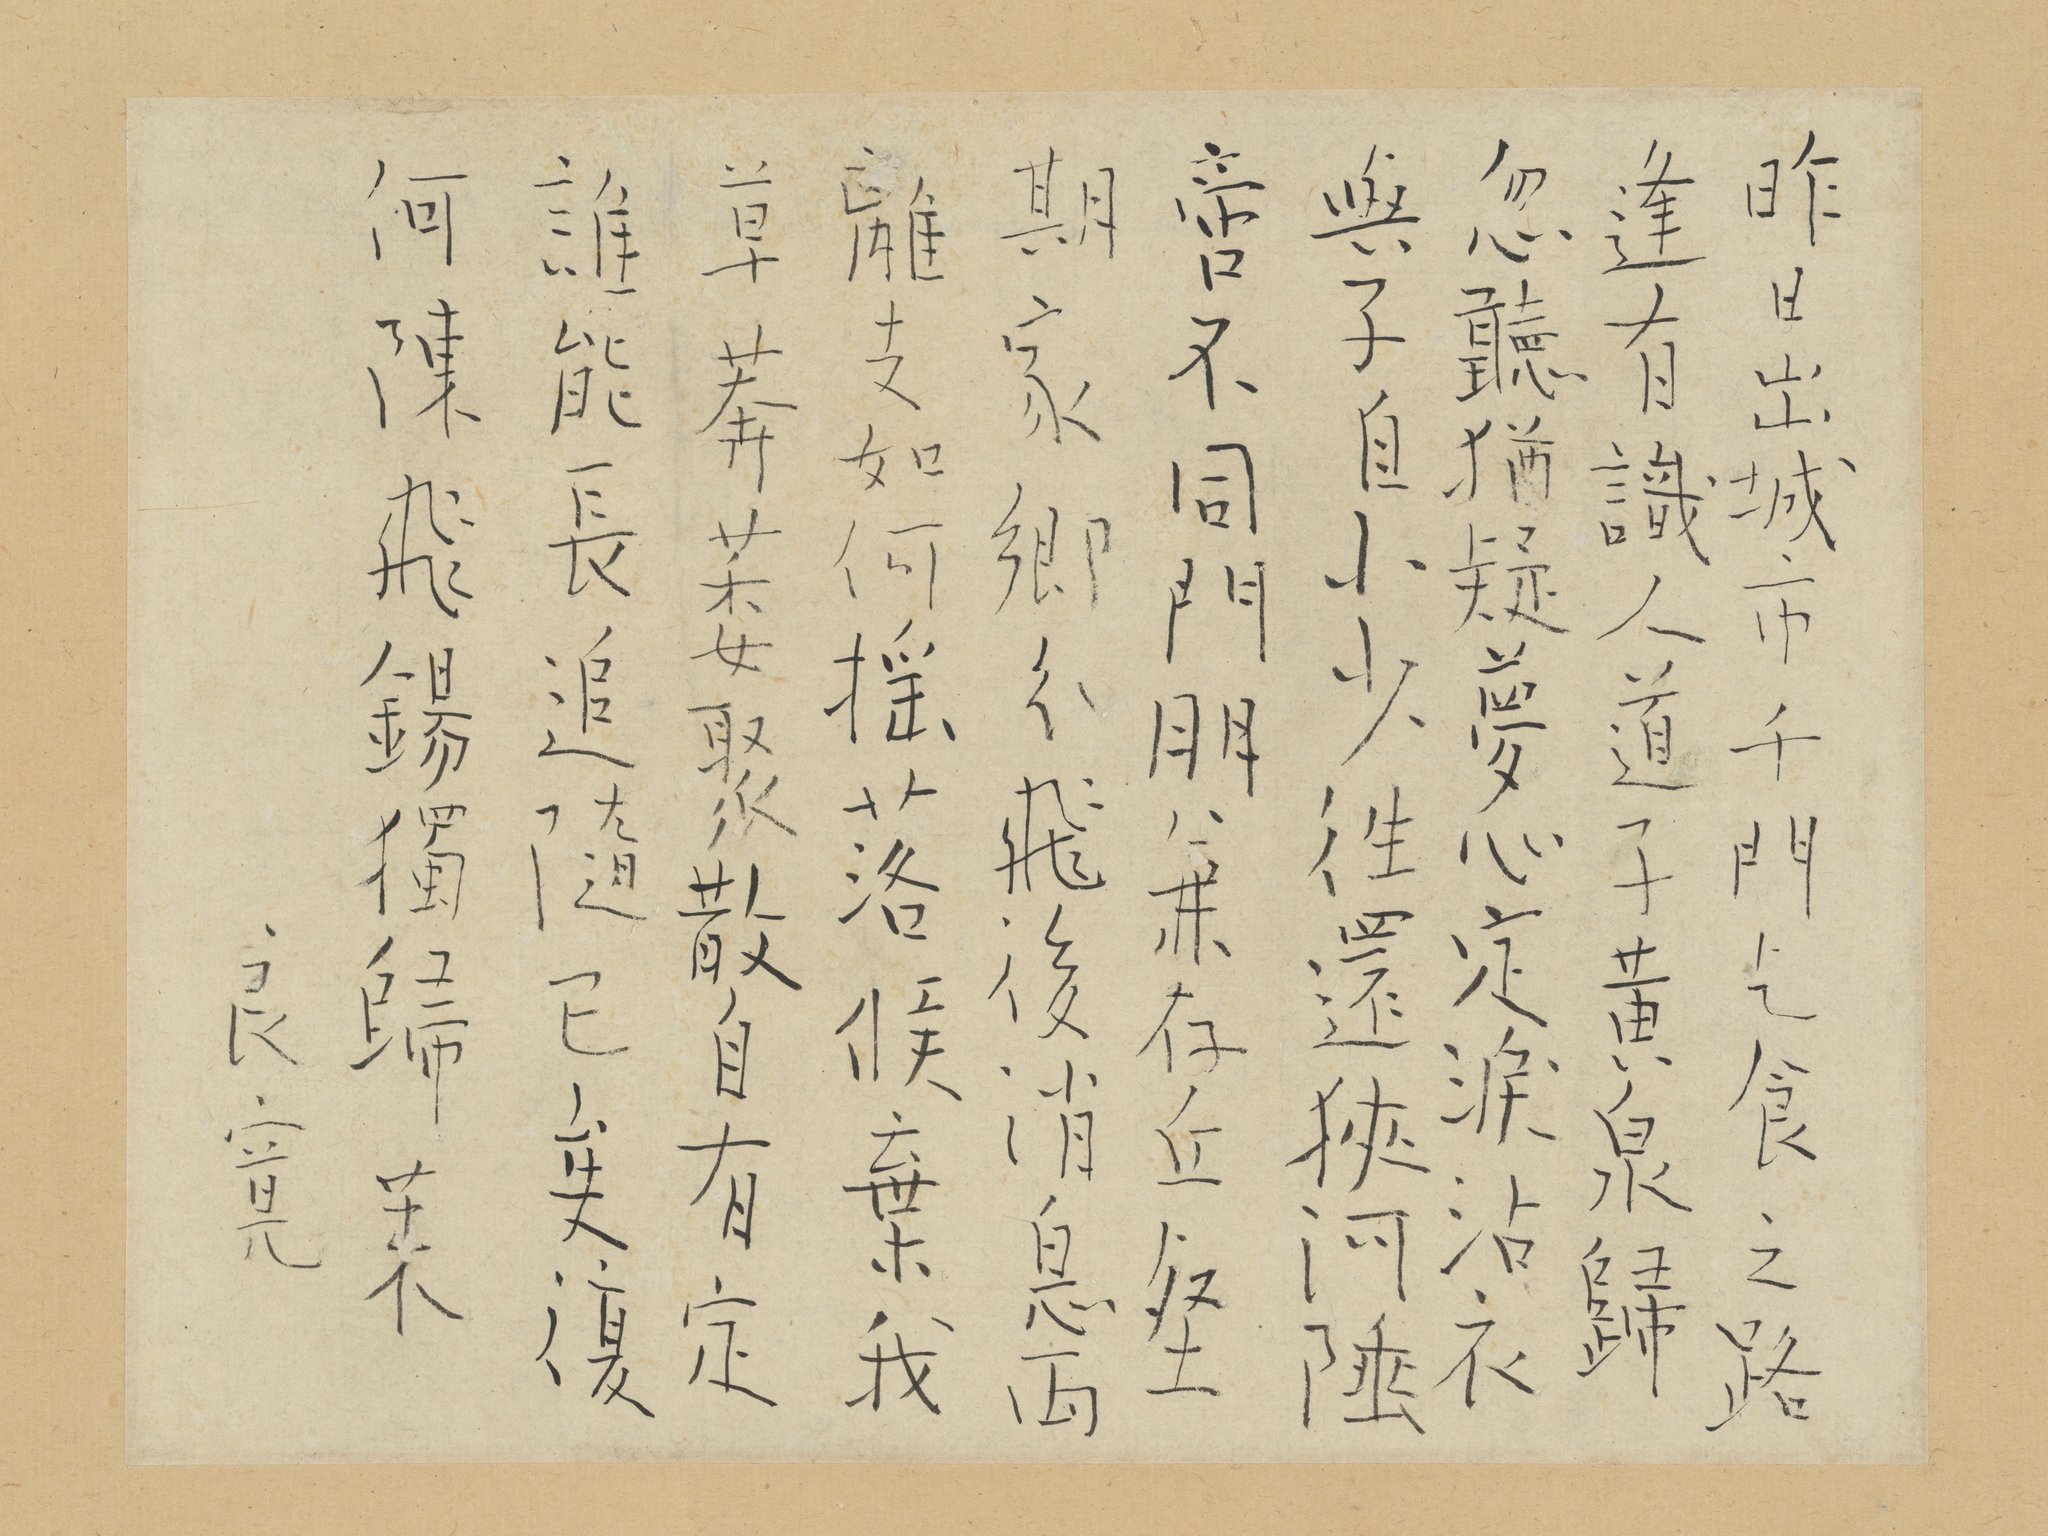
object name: hanging scroll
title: Chinese Poem Lamenting the Death of a Friend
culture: japanese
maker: ryōkan taigu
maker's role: artist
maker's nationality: japanese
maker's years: 1758-1831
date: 1801-1833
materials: ink, paper